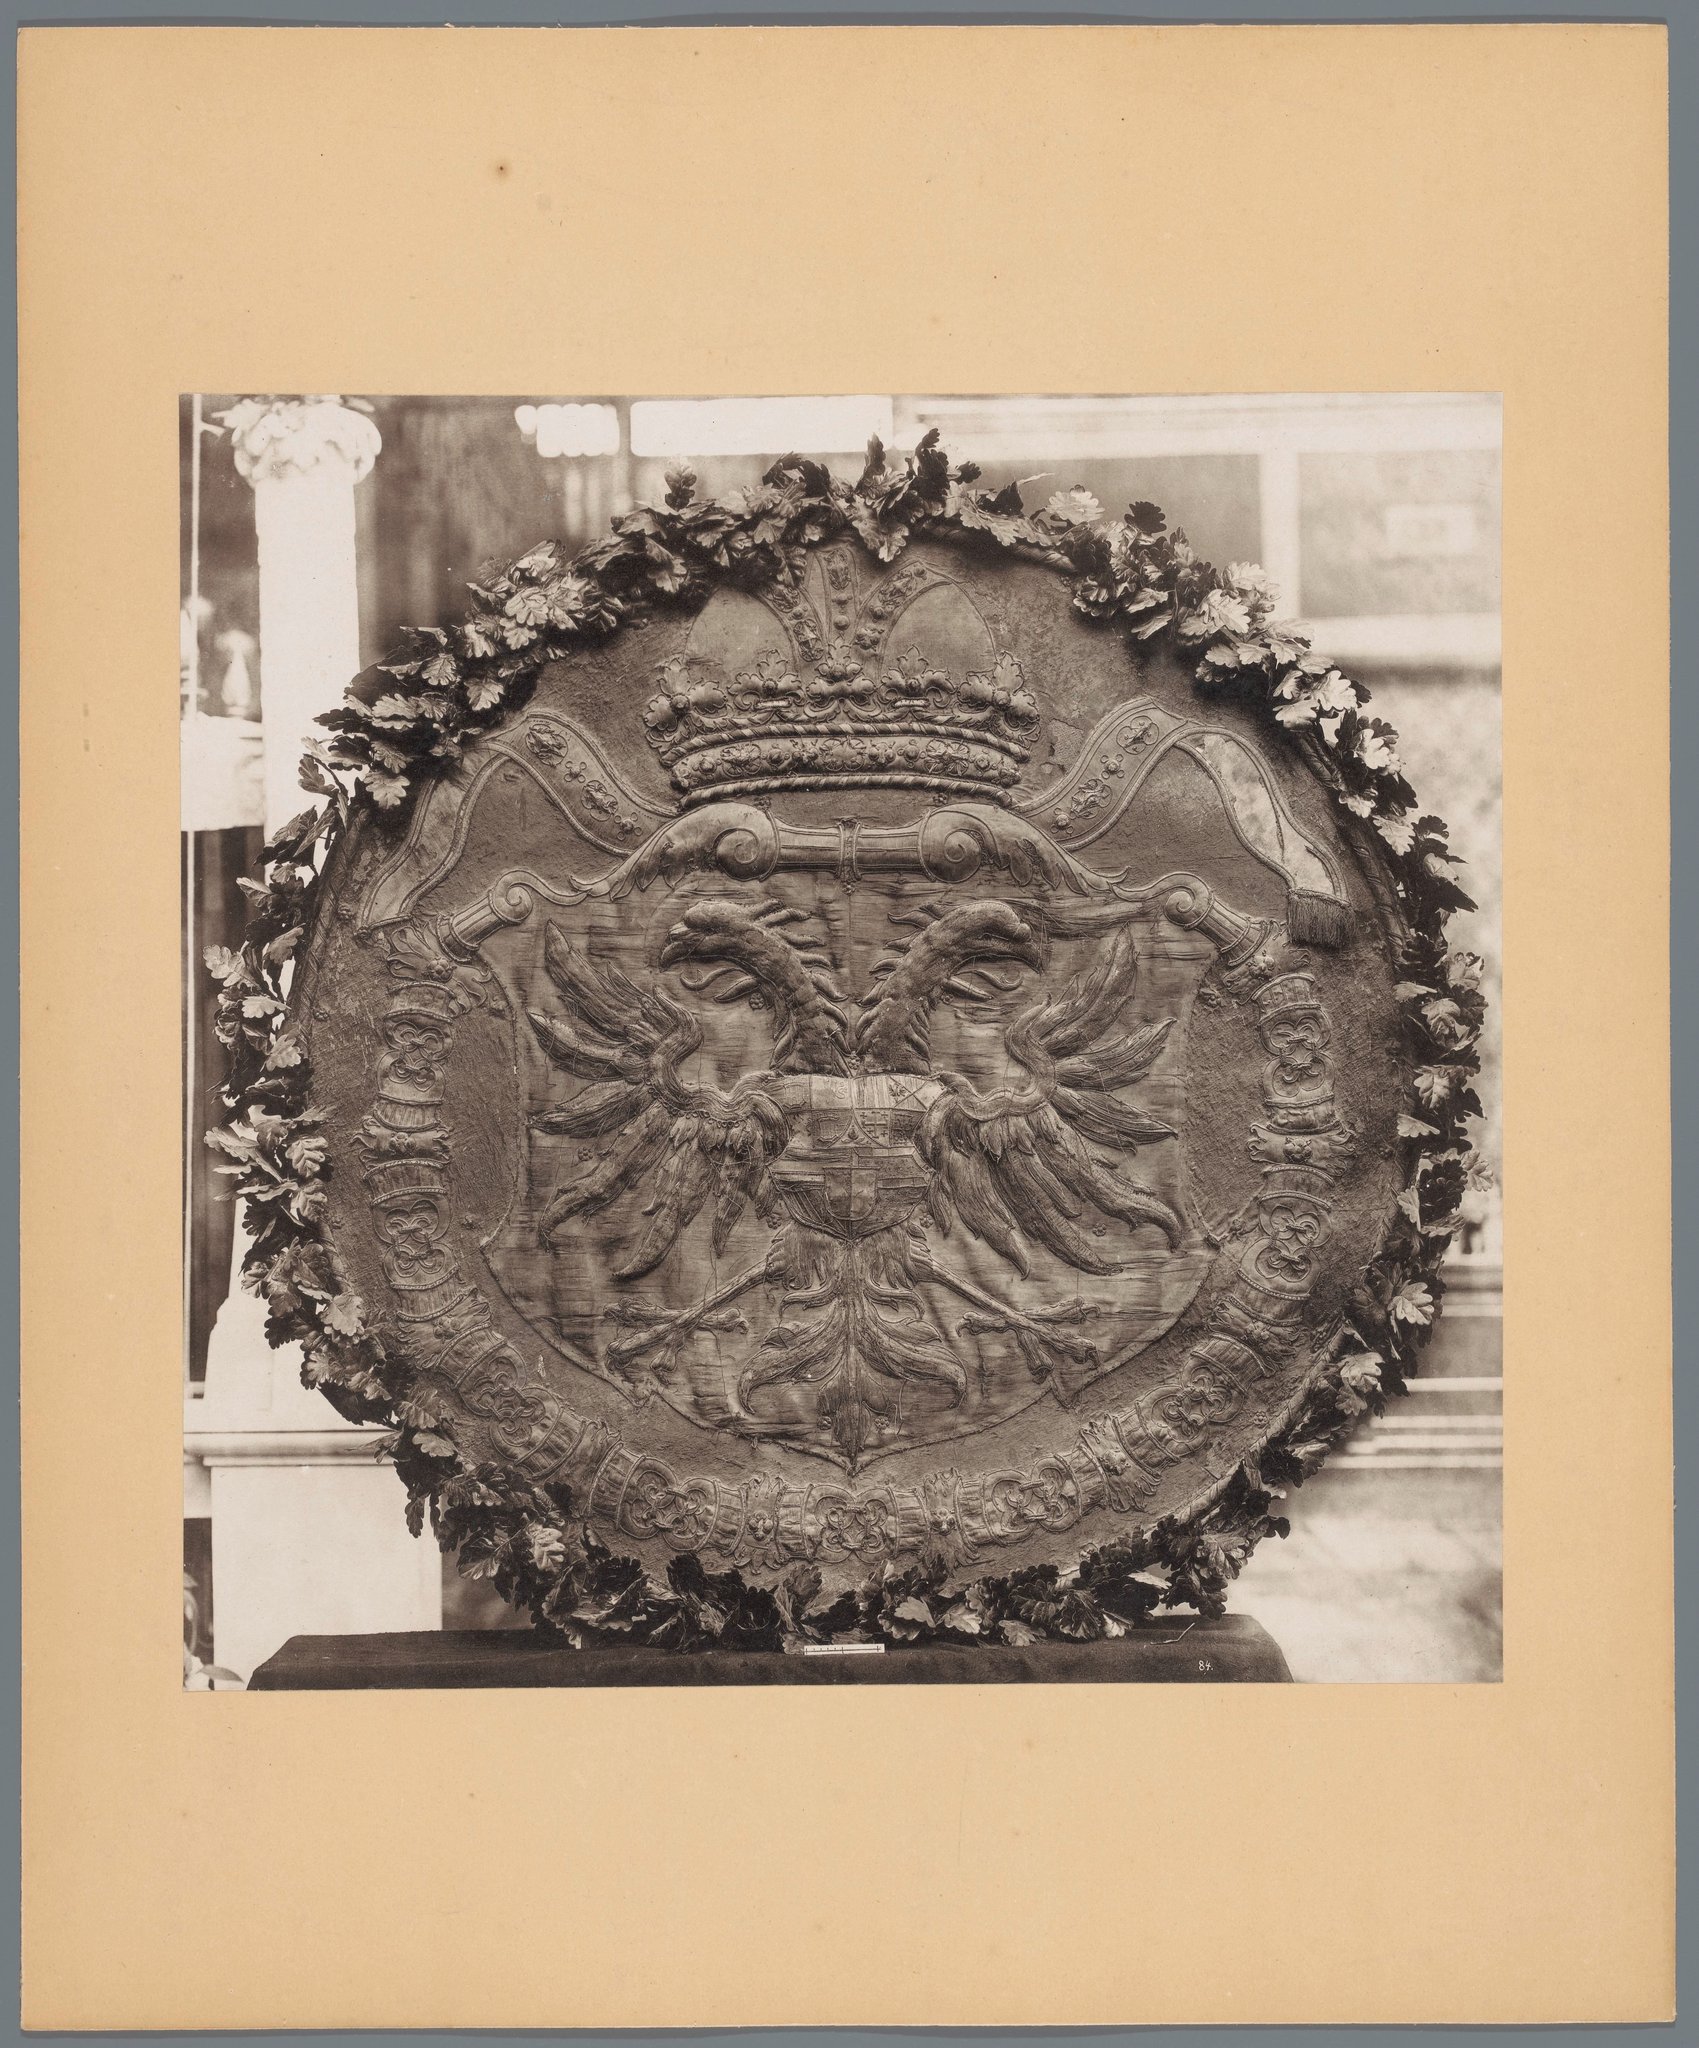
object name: photograph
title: Wapenschild met een tweekoppige adelaar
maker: Anonymous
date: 1875-1900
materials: cardboard, paper, ink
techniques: photograph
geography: europe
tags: double-headed eagle, coat of arms (as symbol of the state, etc.), europe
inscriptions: collector's mark: Lugt 3937, number: ‘84.’